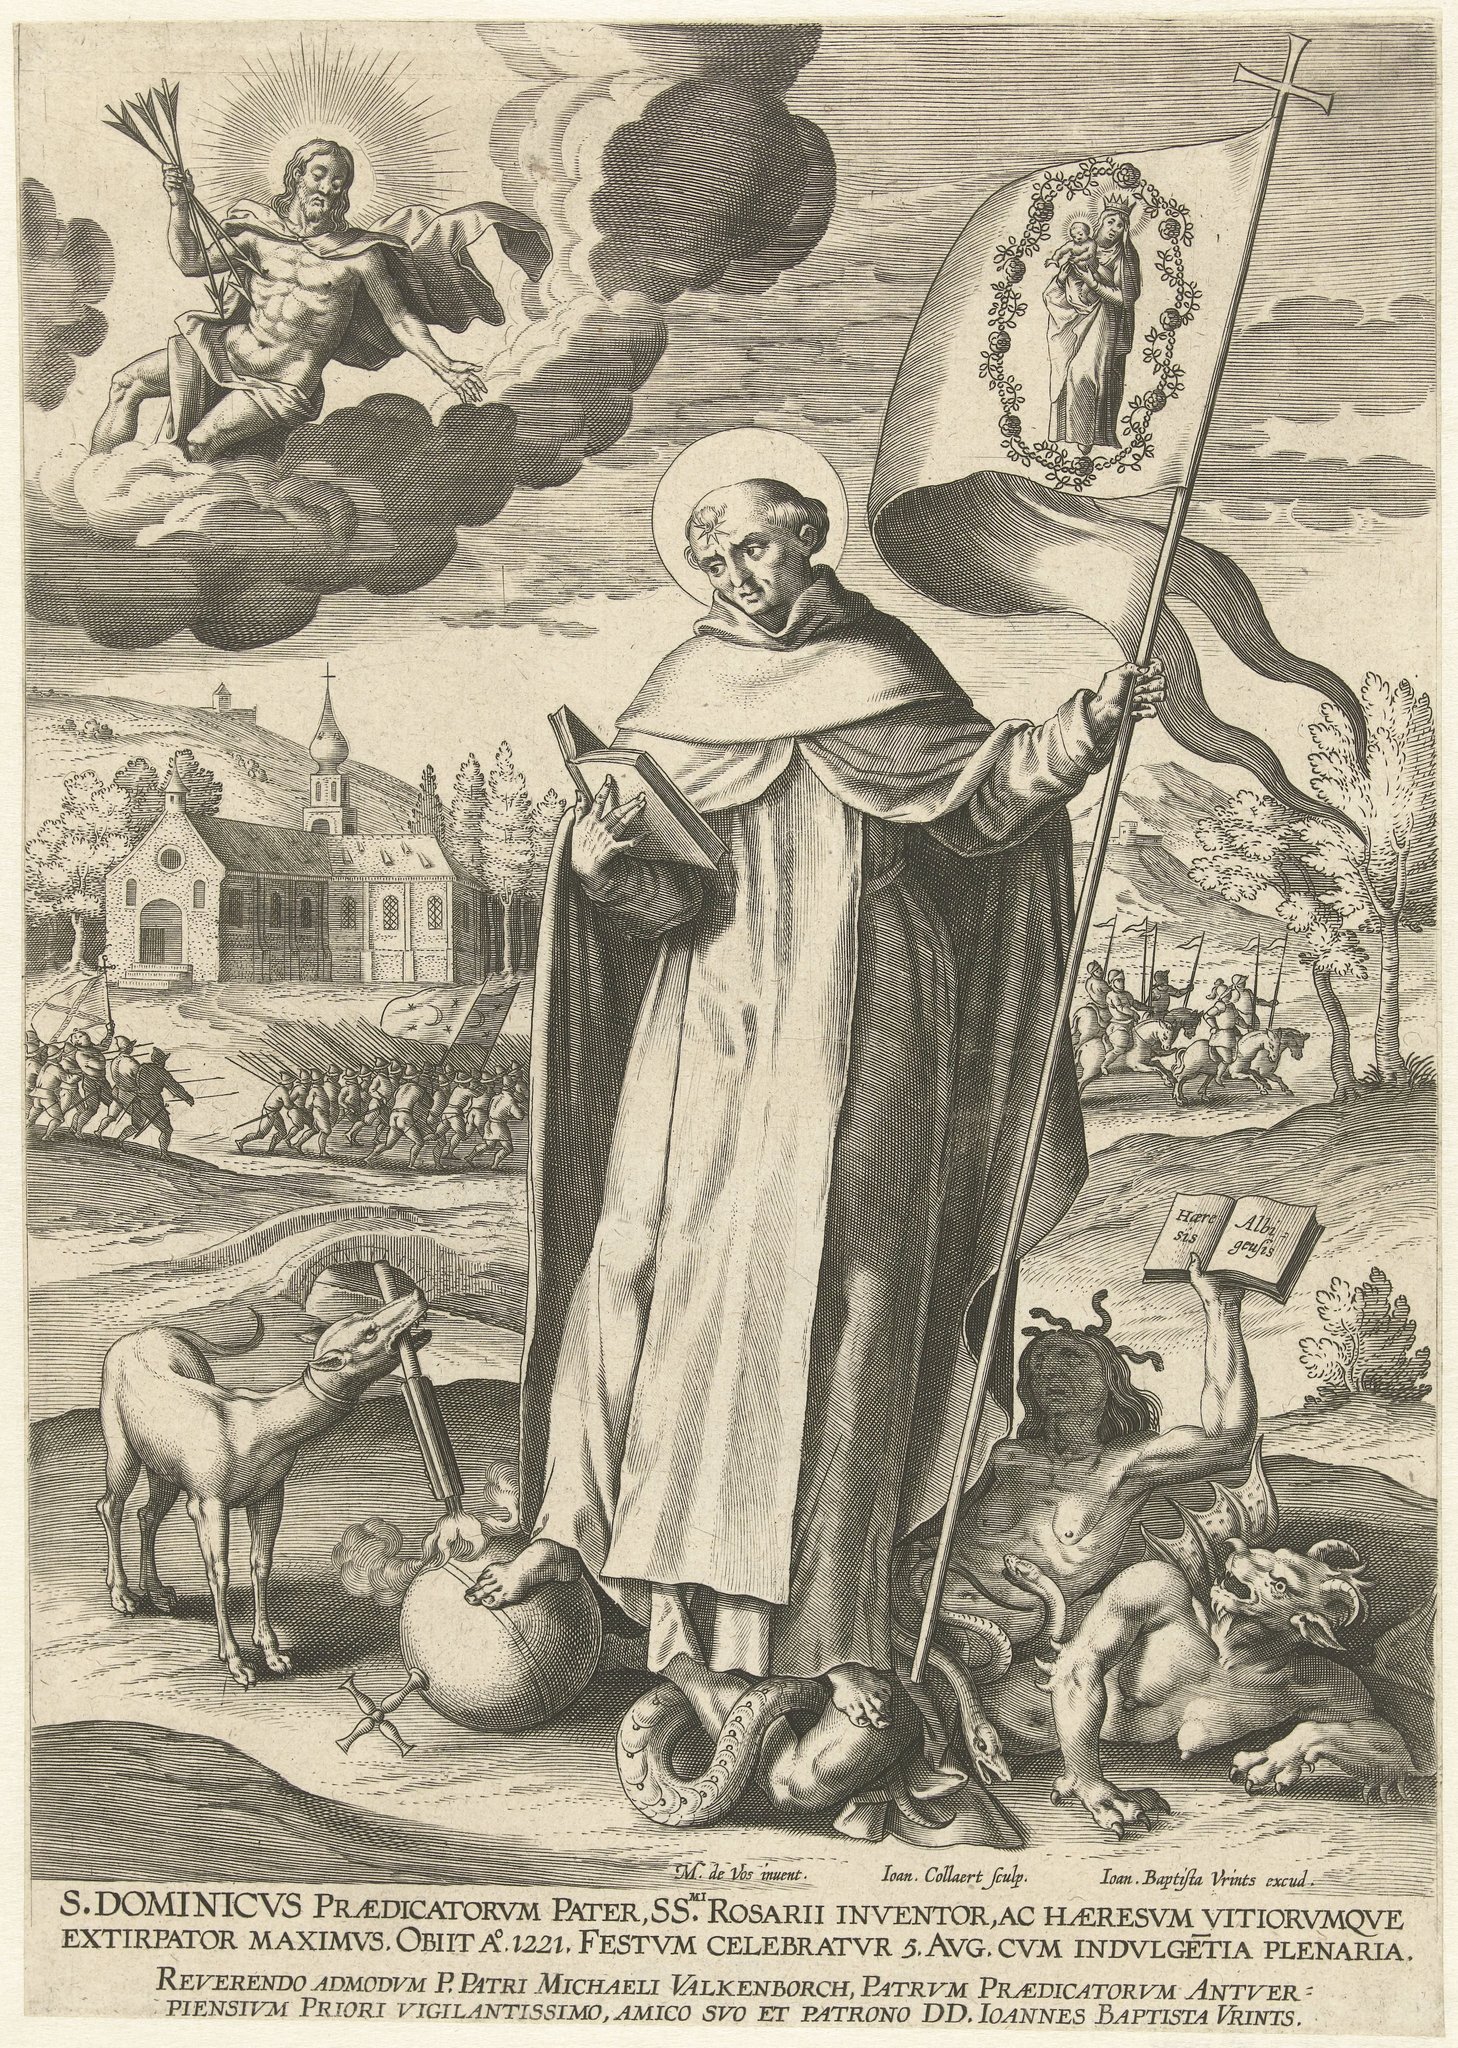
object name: print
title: Heilige Dominicus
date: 1576-1628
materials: paper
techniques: engraving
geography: antwerp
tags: dominic(us) guzman of calerueja, founder of the order of preachers (or dominican (black) friars; possible attributes: book, dog with flaming torch, lily, loaf of bread, rosary, star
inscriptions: collector's mark: Lugt 2228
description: De Heilige Dominicus draagt het habijt van zijn orde. In zijn hand een boek en een vlag waarop Maria in een rozenkrans. Op zijn voorhoofd een ster. Dominicus vertrapt de ketterijen van de Albigenzen. Naast hem zijn attribuut: een hond met een brandende toorts in zijn bek ('Domini Canis'). In de linkerbovenhoek het visioen van Christus met drie pijlen, de deugden van de dominicaner-orde: gehoorzaamheid, armoede en kuisheid. Op de achtergrond een voorbijtrekkend leger. De prent heeft een Latijns onderschrift.